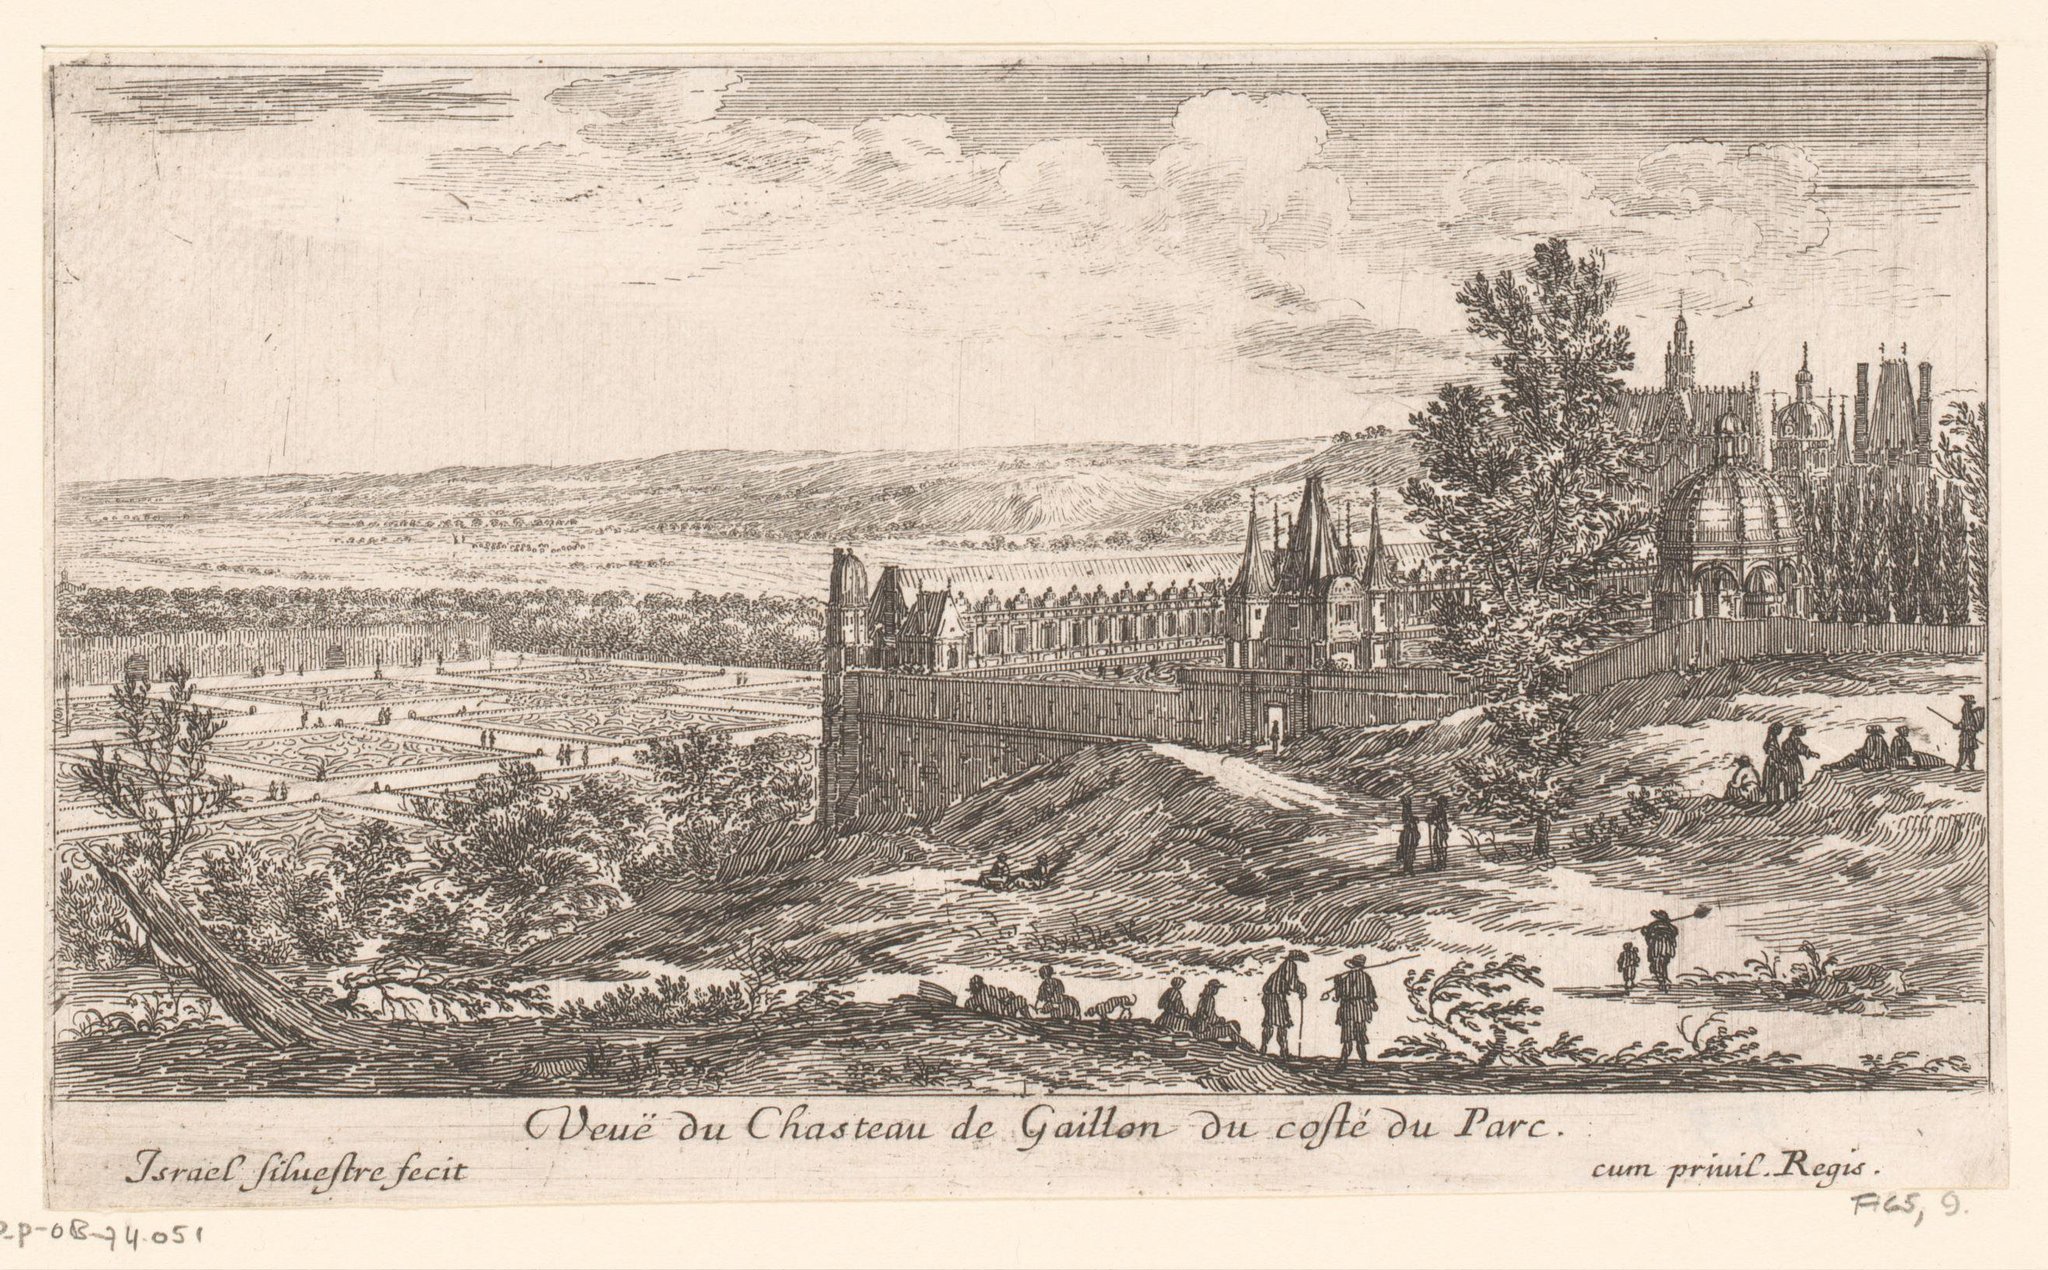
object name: print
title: Veue du Chasteau de Gaillon du costé du Parc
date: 1657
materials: paper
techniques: engraving, etching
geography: france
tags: french or architectonic garden; formal garden, landscape with tower or castle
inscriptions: collector's mark: Lugt 240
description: Prent maakt deel uit van een ongenummerde serie van negen prenten.